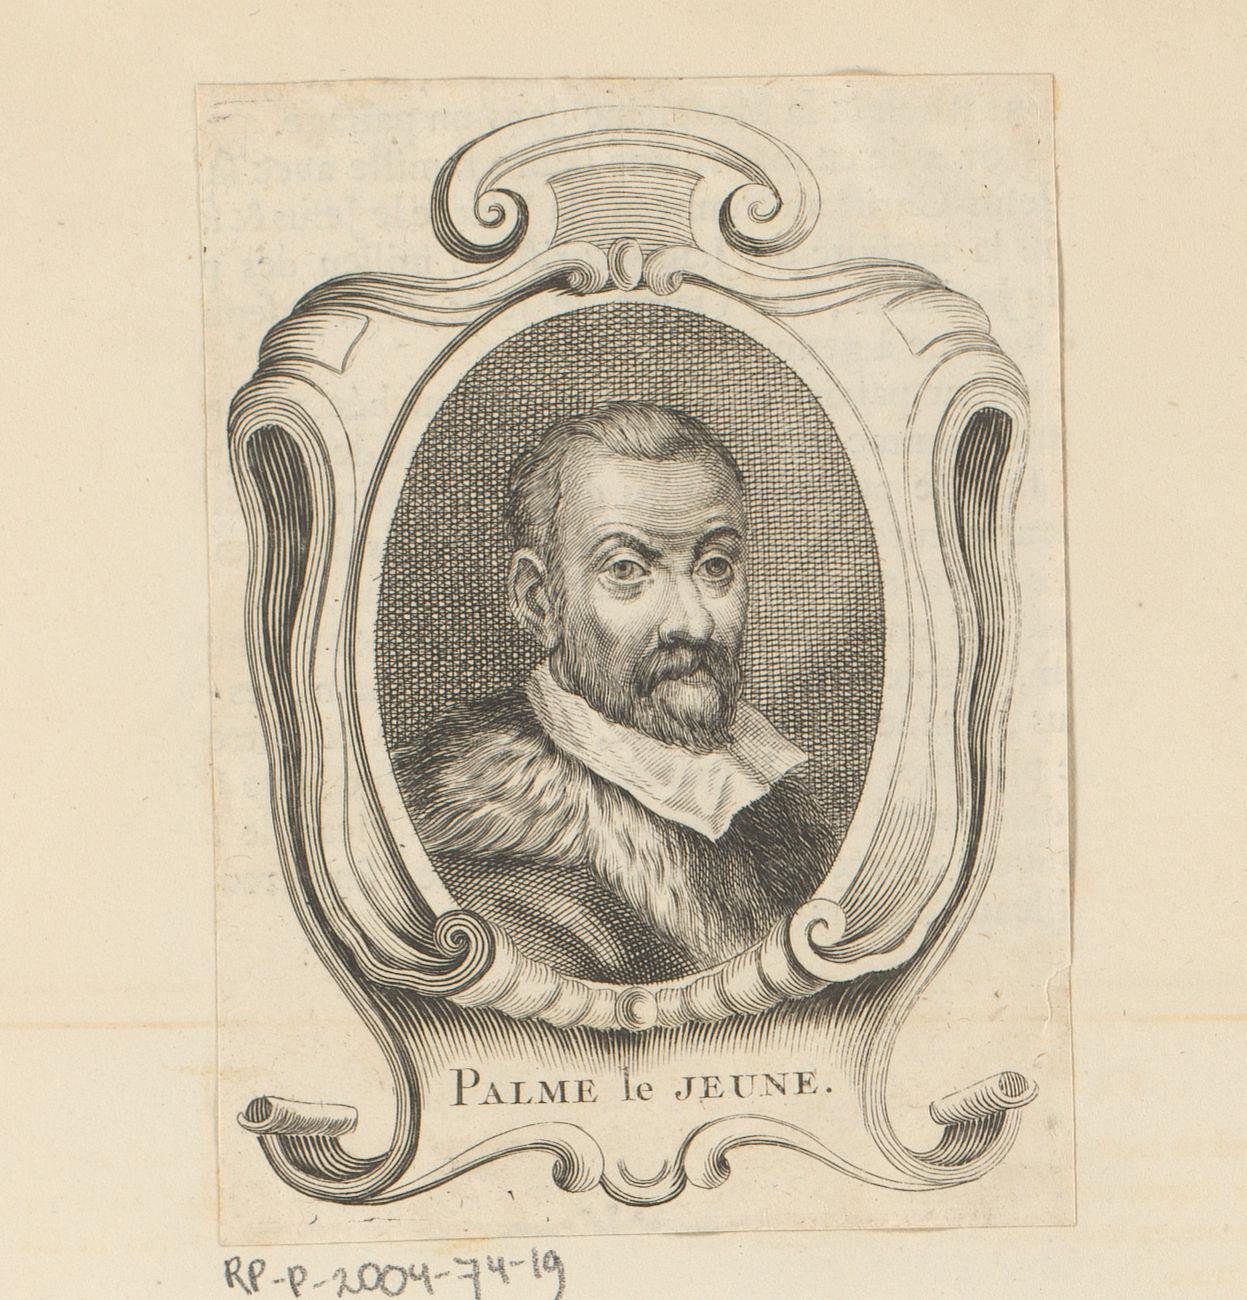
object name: print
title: Portret van Jacopo Palma (il Giovane)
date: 1745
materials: paper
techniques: engraving, letterpress printing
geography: paris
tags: venice, draughtsman, jacopo palma (il giovane), historical persons, portrait, self-portrait of painter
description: Prent uit: Dézallier d'Argenville, Antoine Joseph. Abrégé de la vie des plus fameux peintres. 4 dln. Parijs: De Bure l'aîné, 1745, dl. 1, p. 194. De samensteller heeft deze prent in het album geplakt als illustratie bij: Pilkington, Matthew en Johann Heinrich Füssli. A dictionary of painters, from the revival of the art to the present period. 4 dln. Londen: John Crowder, 1805, dl. 3, p. 381.